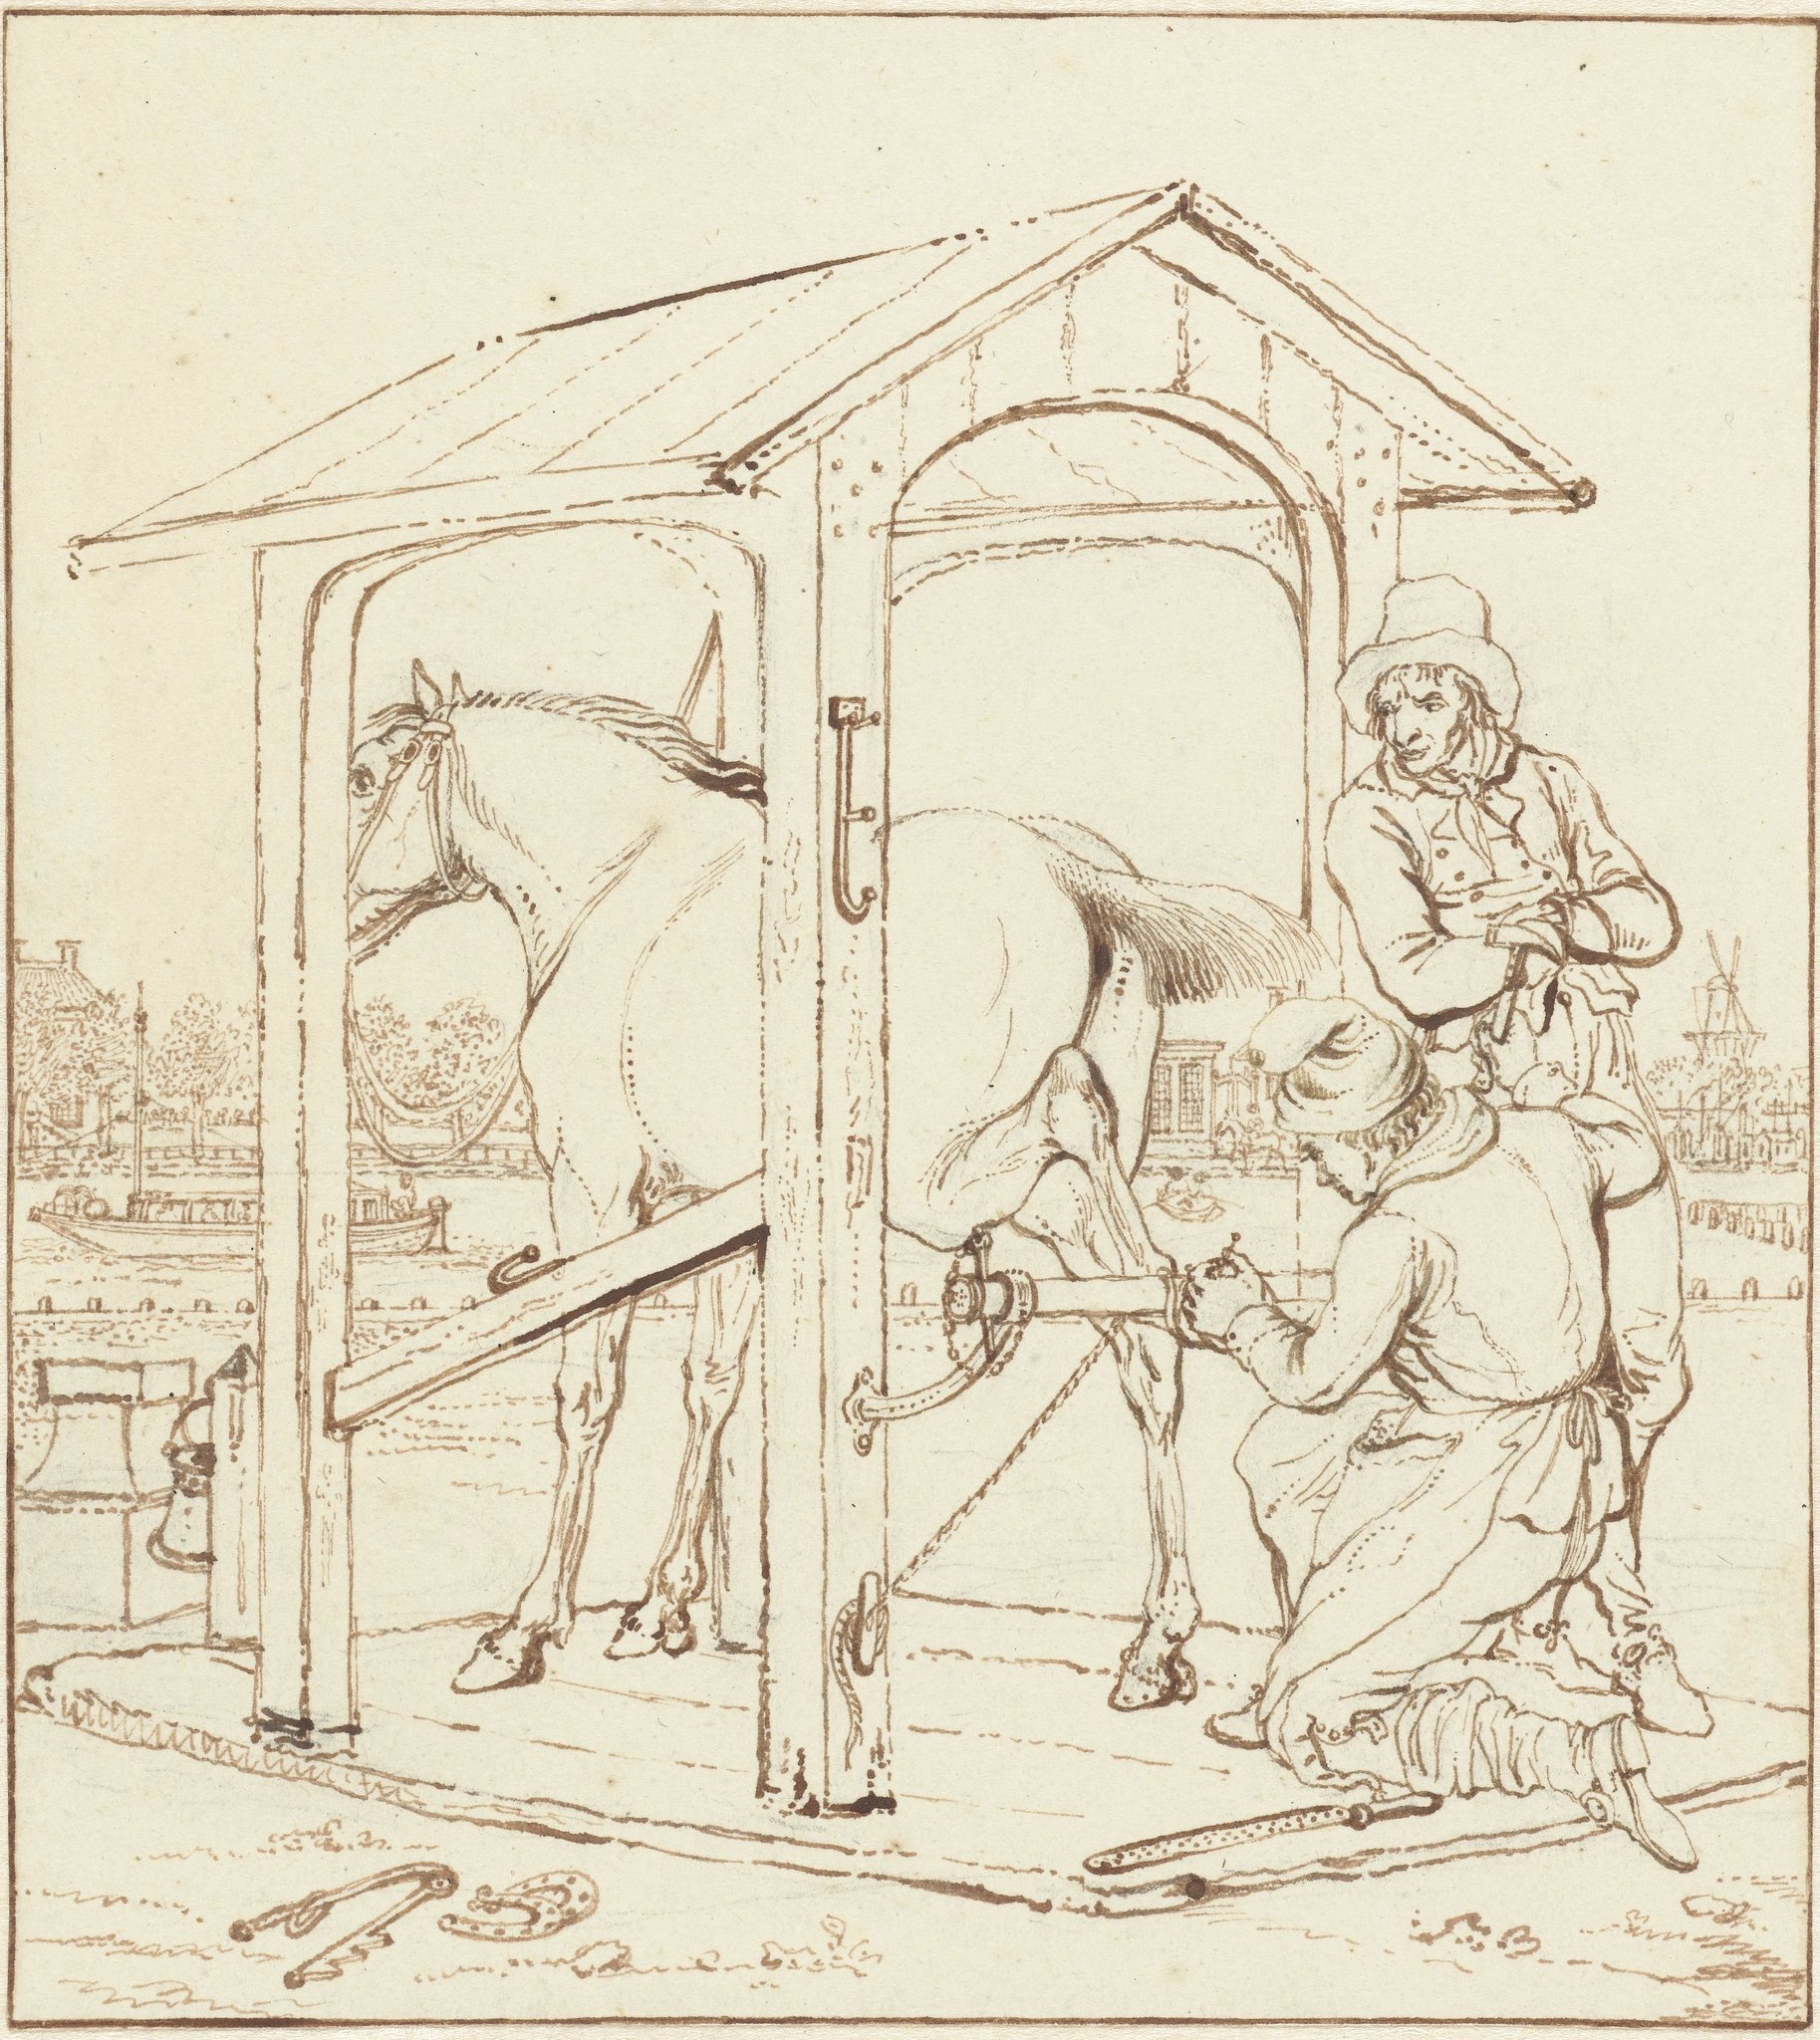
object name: drawing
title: Het beslaan van een paard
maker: johannes vinkeles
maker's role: draughtsman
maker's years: 1783-1803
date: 1793-1803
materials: ink, paper, pencil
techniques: pen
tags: farrier, shoeing-smith, horse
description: Het beslaan van een paard in een travalje door een hoefsmid; op de achtergrond een rivier met trekschuit.